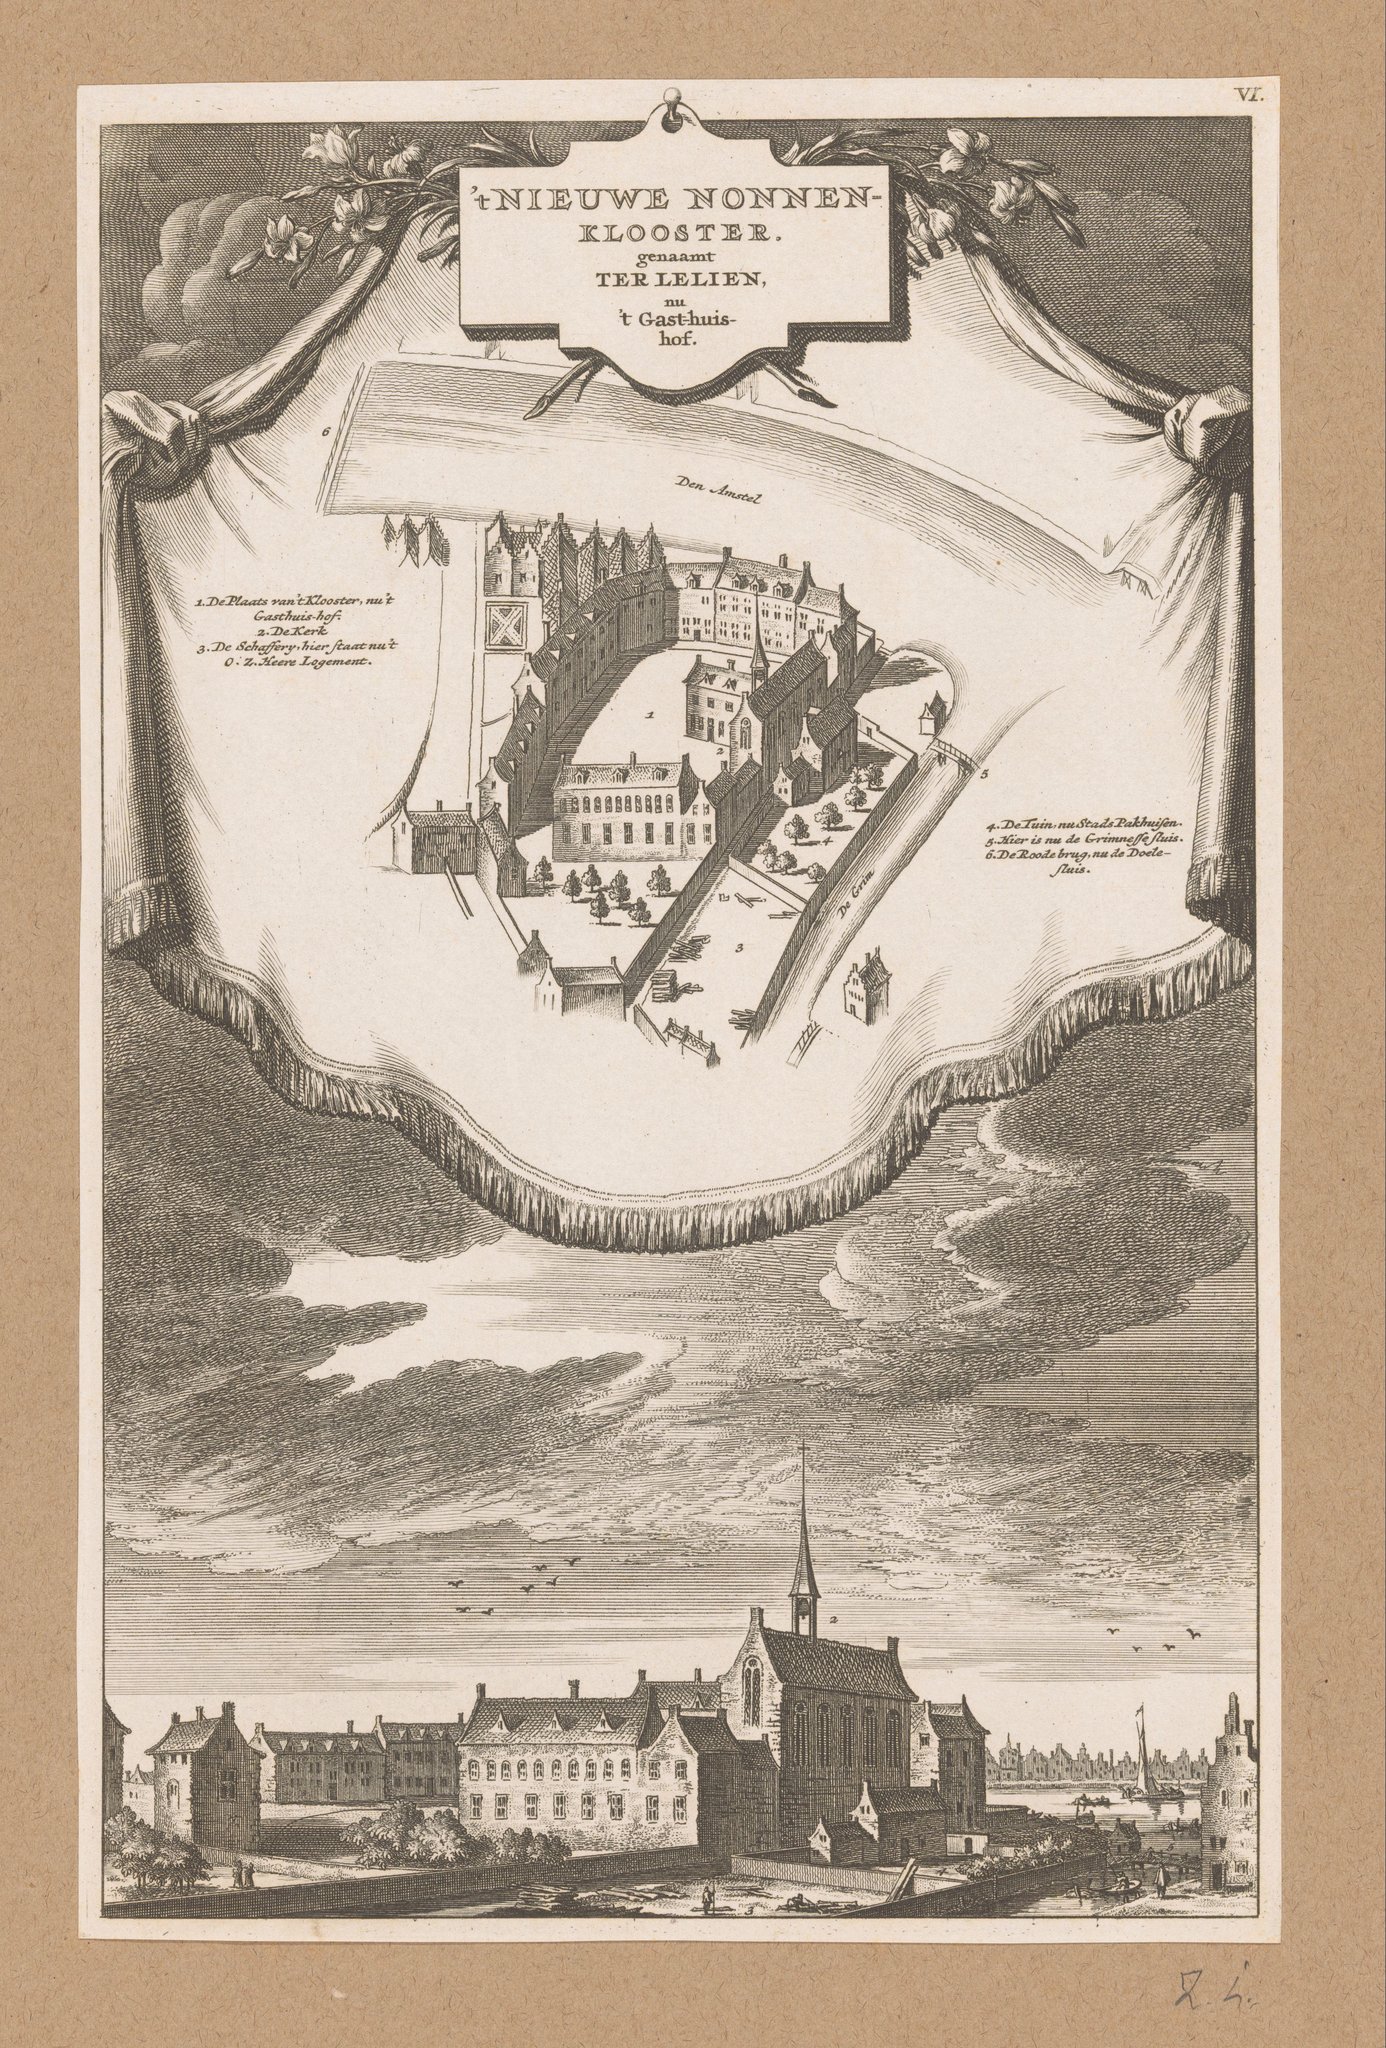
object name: book illustration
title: 't Nieuwe Nonnen-klooster genaamt Ter Lelien, nu 't Gast-huis-hof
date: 1760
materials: paper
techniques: engraving, etching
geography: amsterdam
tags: abbey, monastery, convent ~ roman catholic church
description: Prent ook gebruikt in: Wagenaar, Jan. Amsterdam, in zyne opkomst, aanwas, geschiedenissen (…). 3 dln. [folio-uitgave]. Amsterdam: Isaak Tirion en Yntema & Tieboel, 1760-1767, dl. 1 (Isaac Tirion, 1760). Zie RP-P-AO-24X-12 voor proefdruk. Dat de prent de situatie rond 1544 weergeeft, gaat terug op het feit dat voor het maken van deze en andere prenten van kloosters en kerken van voor de Alteratie (1578) is uitgegaan van de plattegrond van Cornelis Anthonisz. uit 1544 (zie RP-P-OB-70.399 en RP-P-AO-20-15).